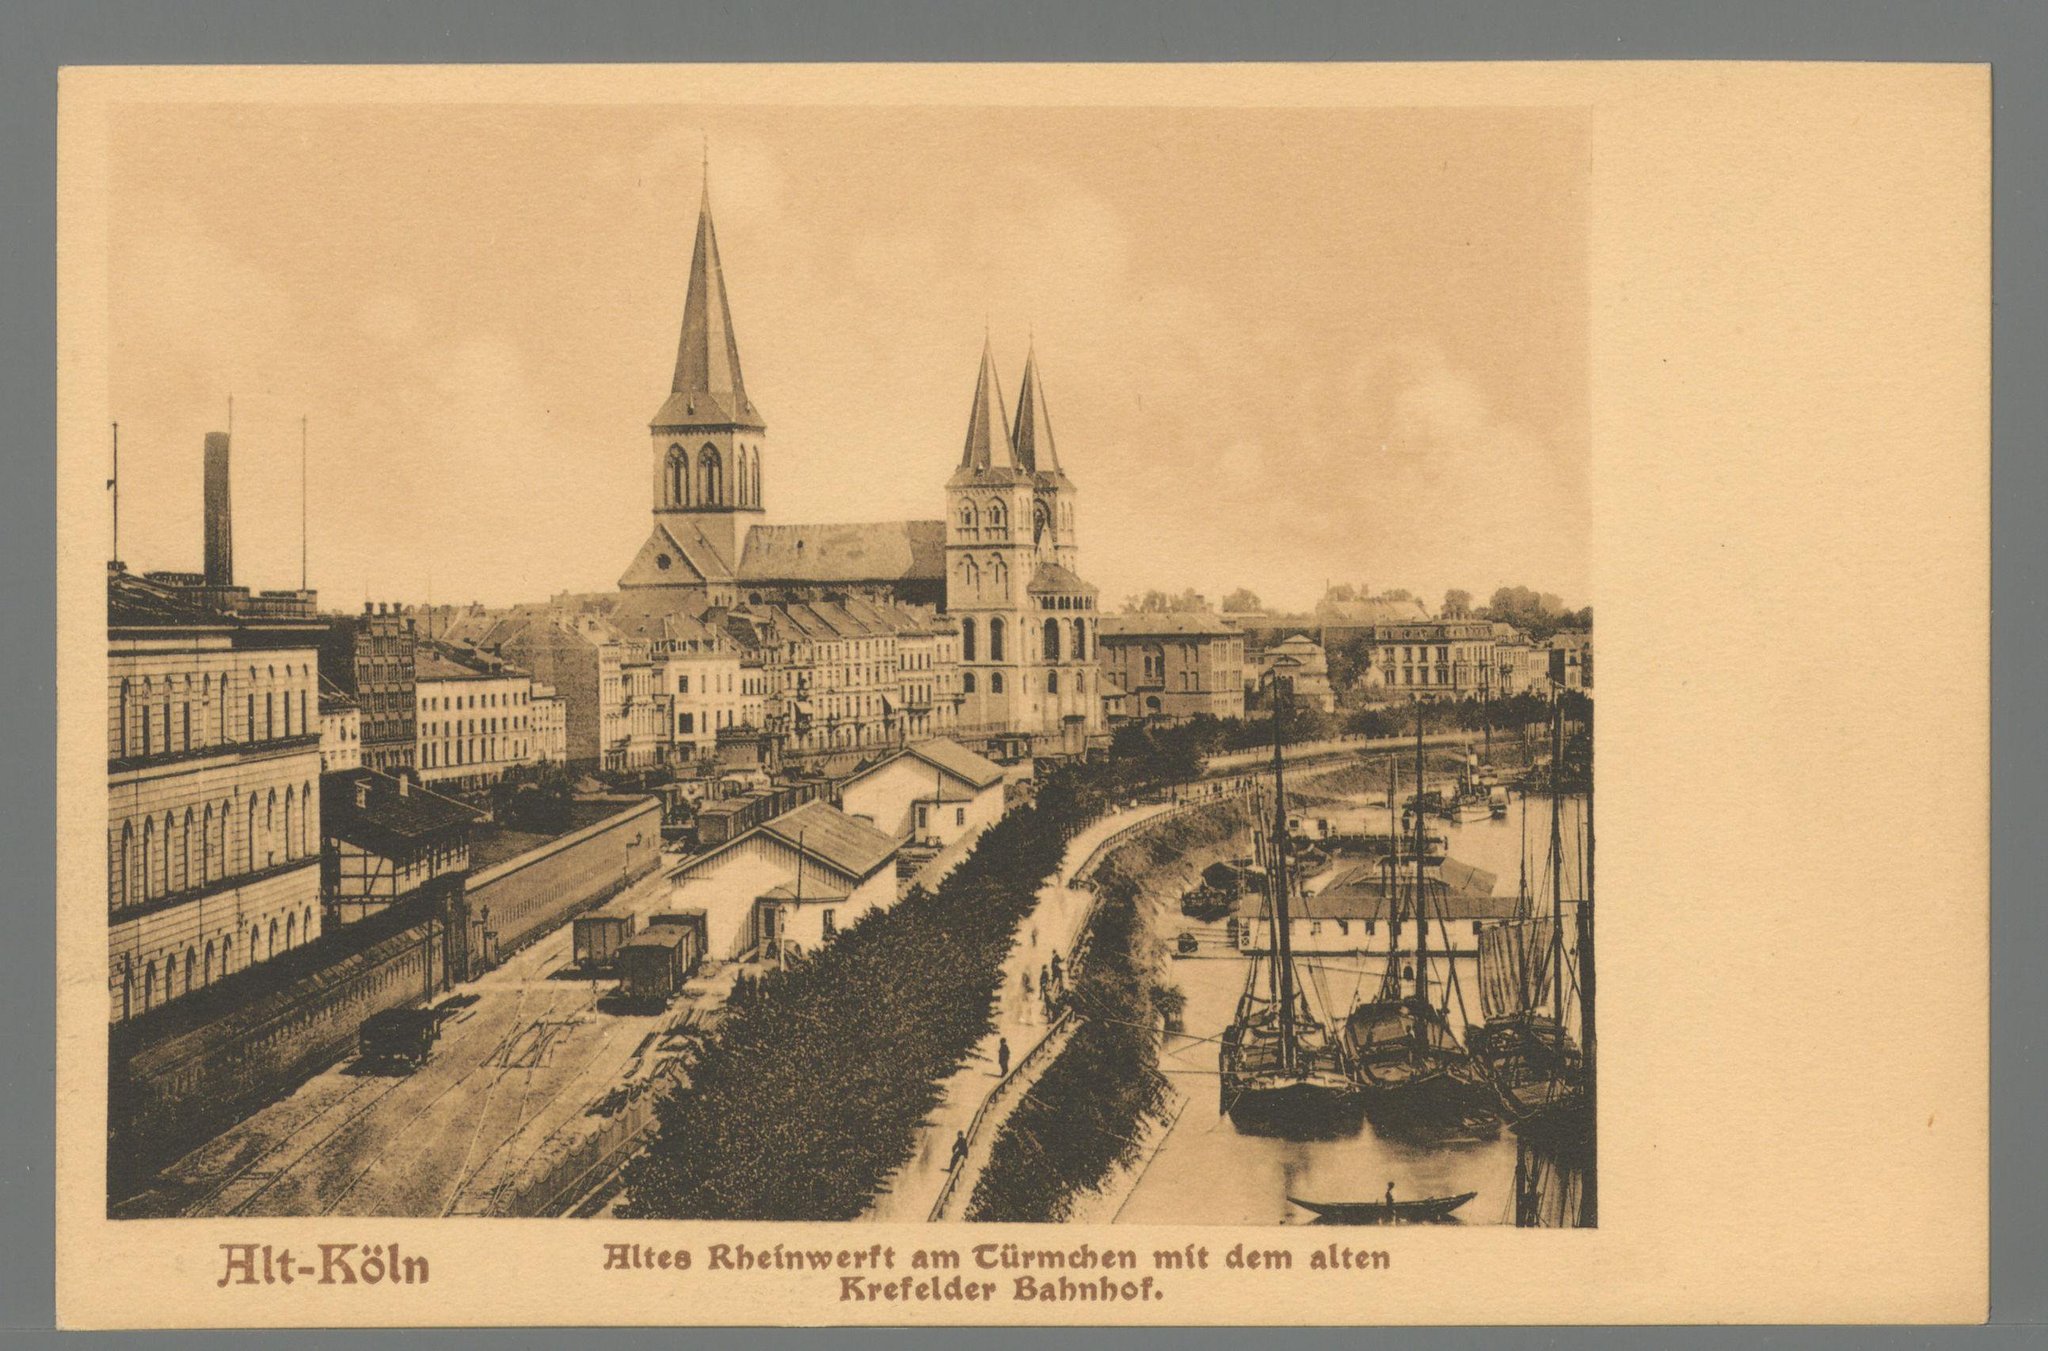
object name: ansichtkaart, prentbriefkaart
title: Alt-Köln. Altes Rheinwerft am Türmchen mit dem alten Krefelder Bahnhof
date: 1905-1920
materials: cardboard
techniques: photograph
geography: cologne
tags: church (exterior), station; shelter (railway, tramway), cologne